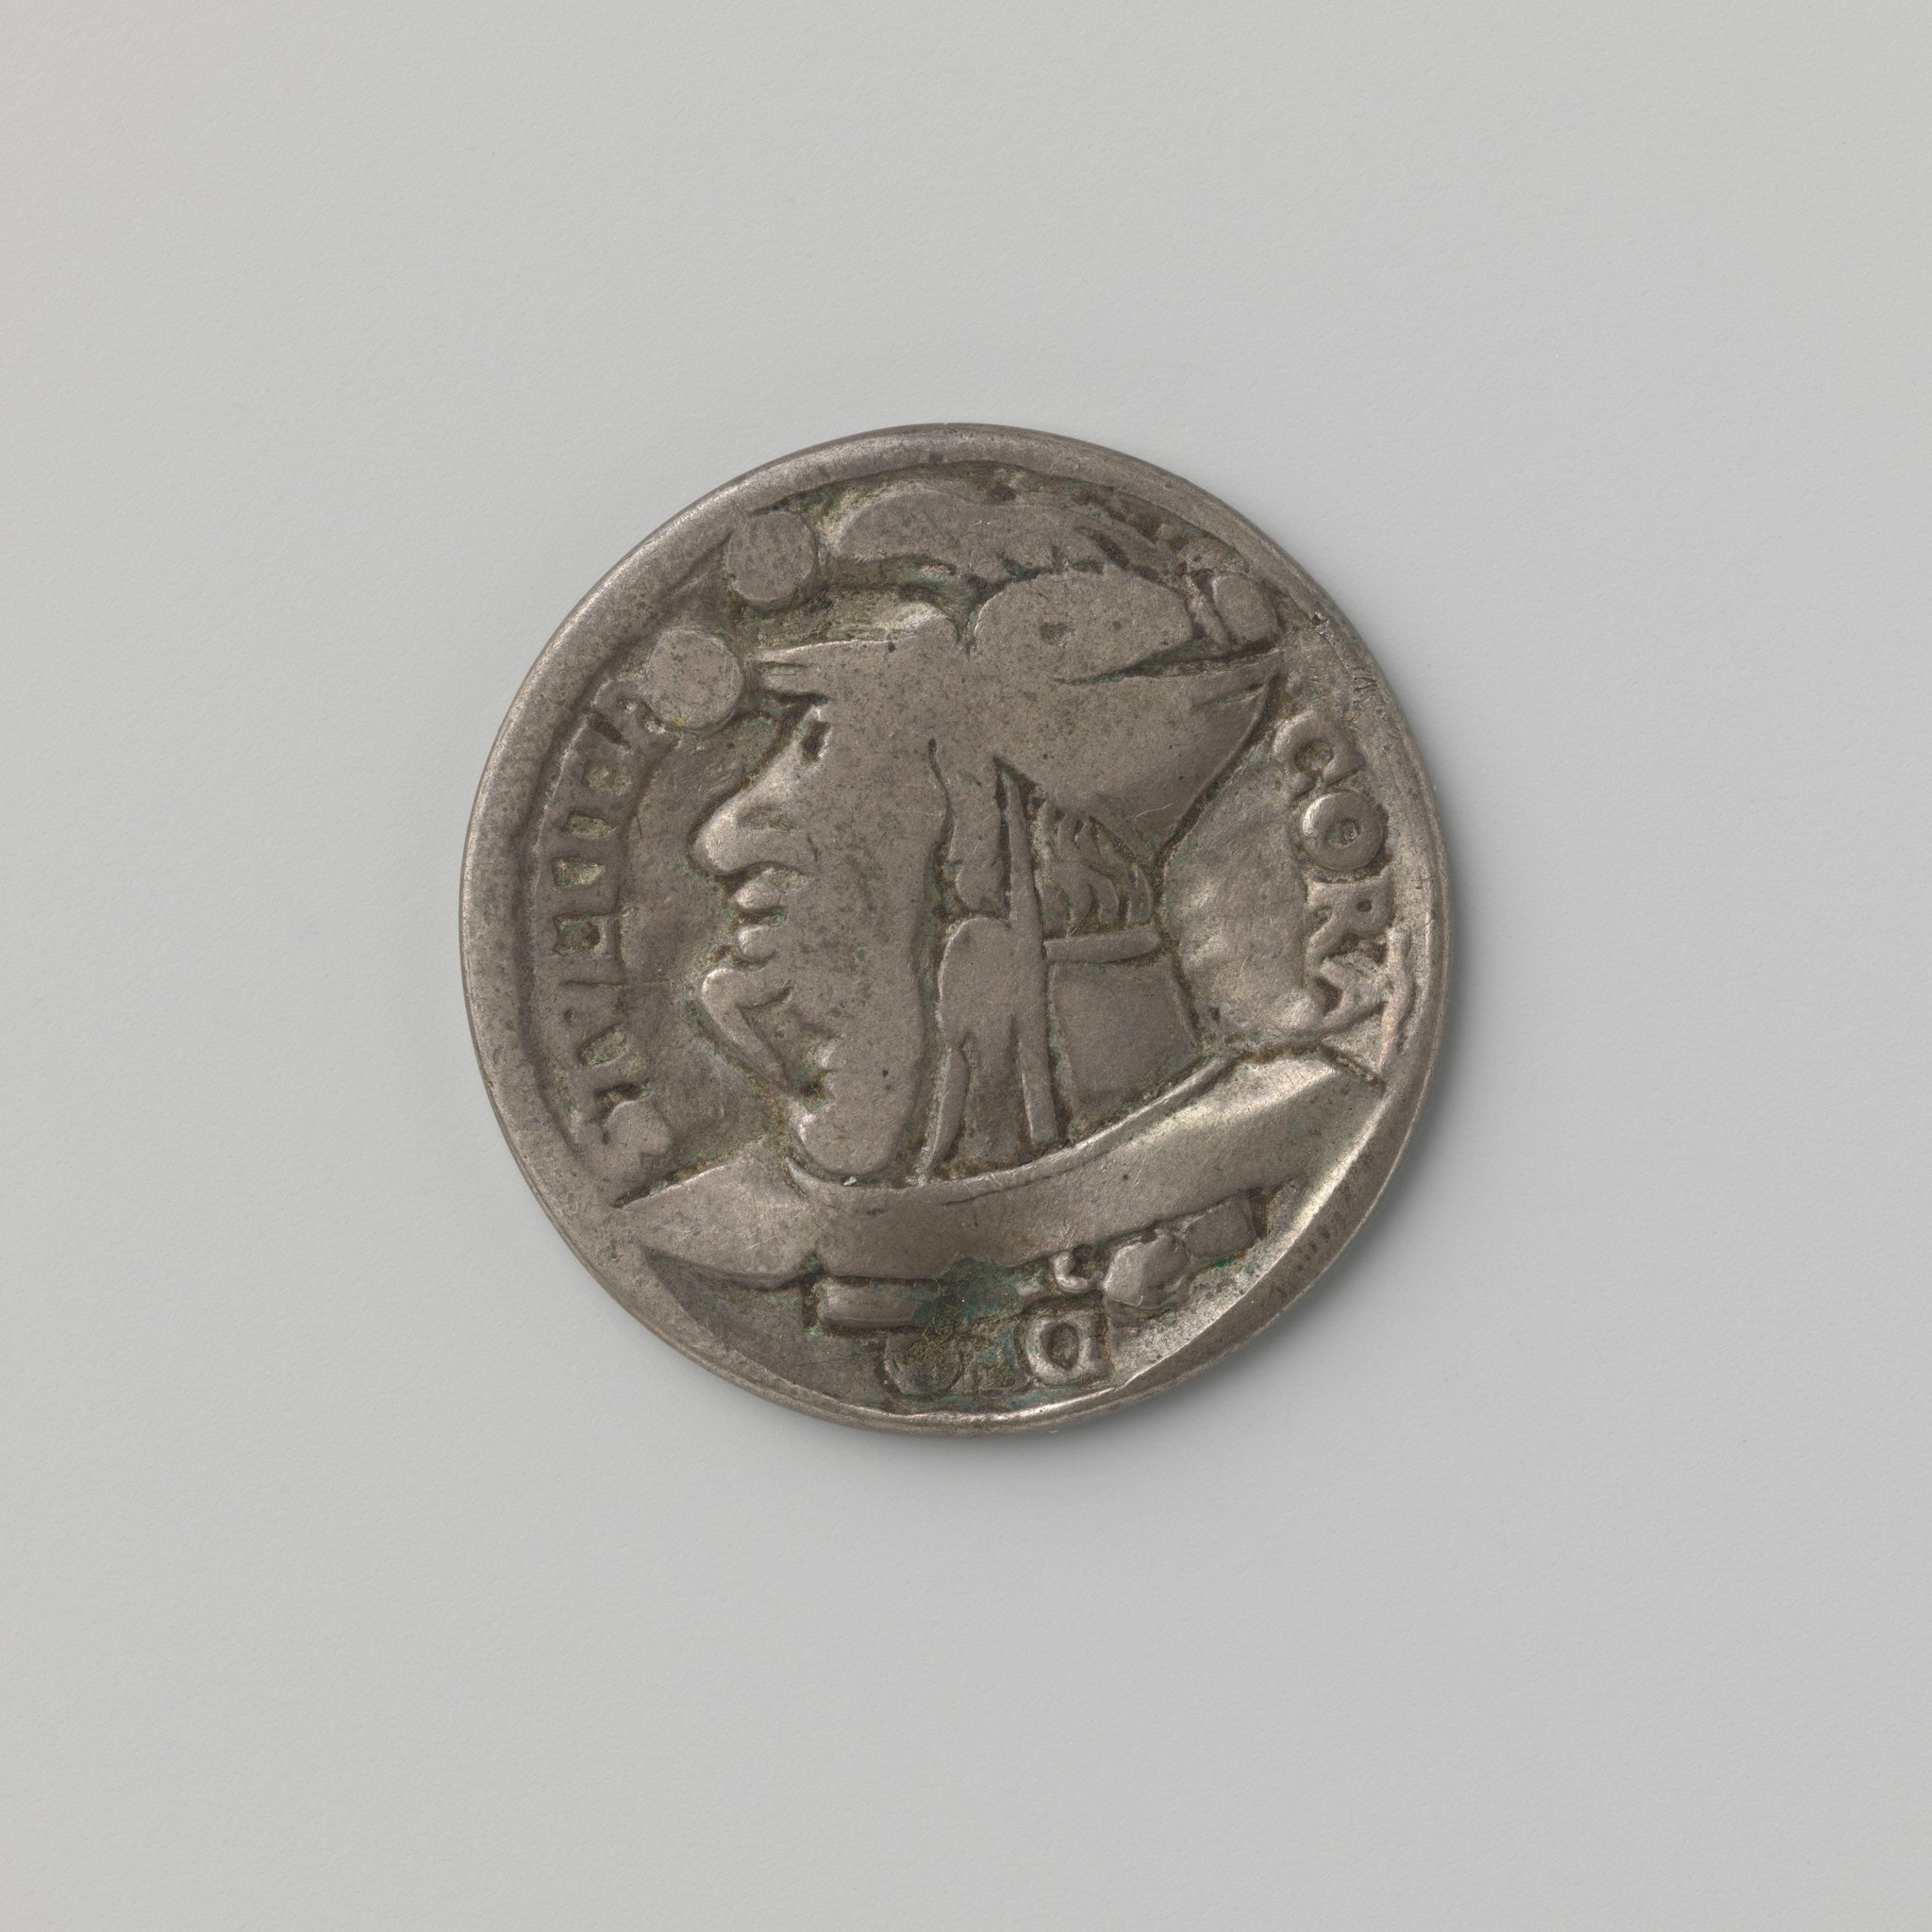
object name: medal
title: Concilie van Trente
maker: Anonymous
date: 1545-1563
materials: silver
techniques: casting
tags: concilie van trente